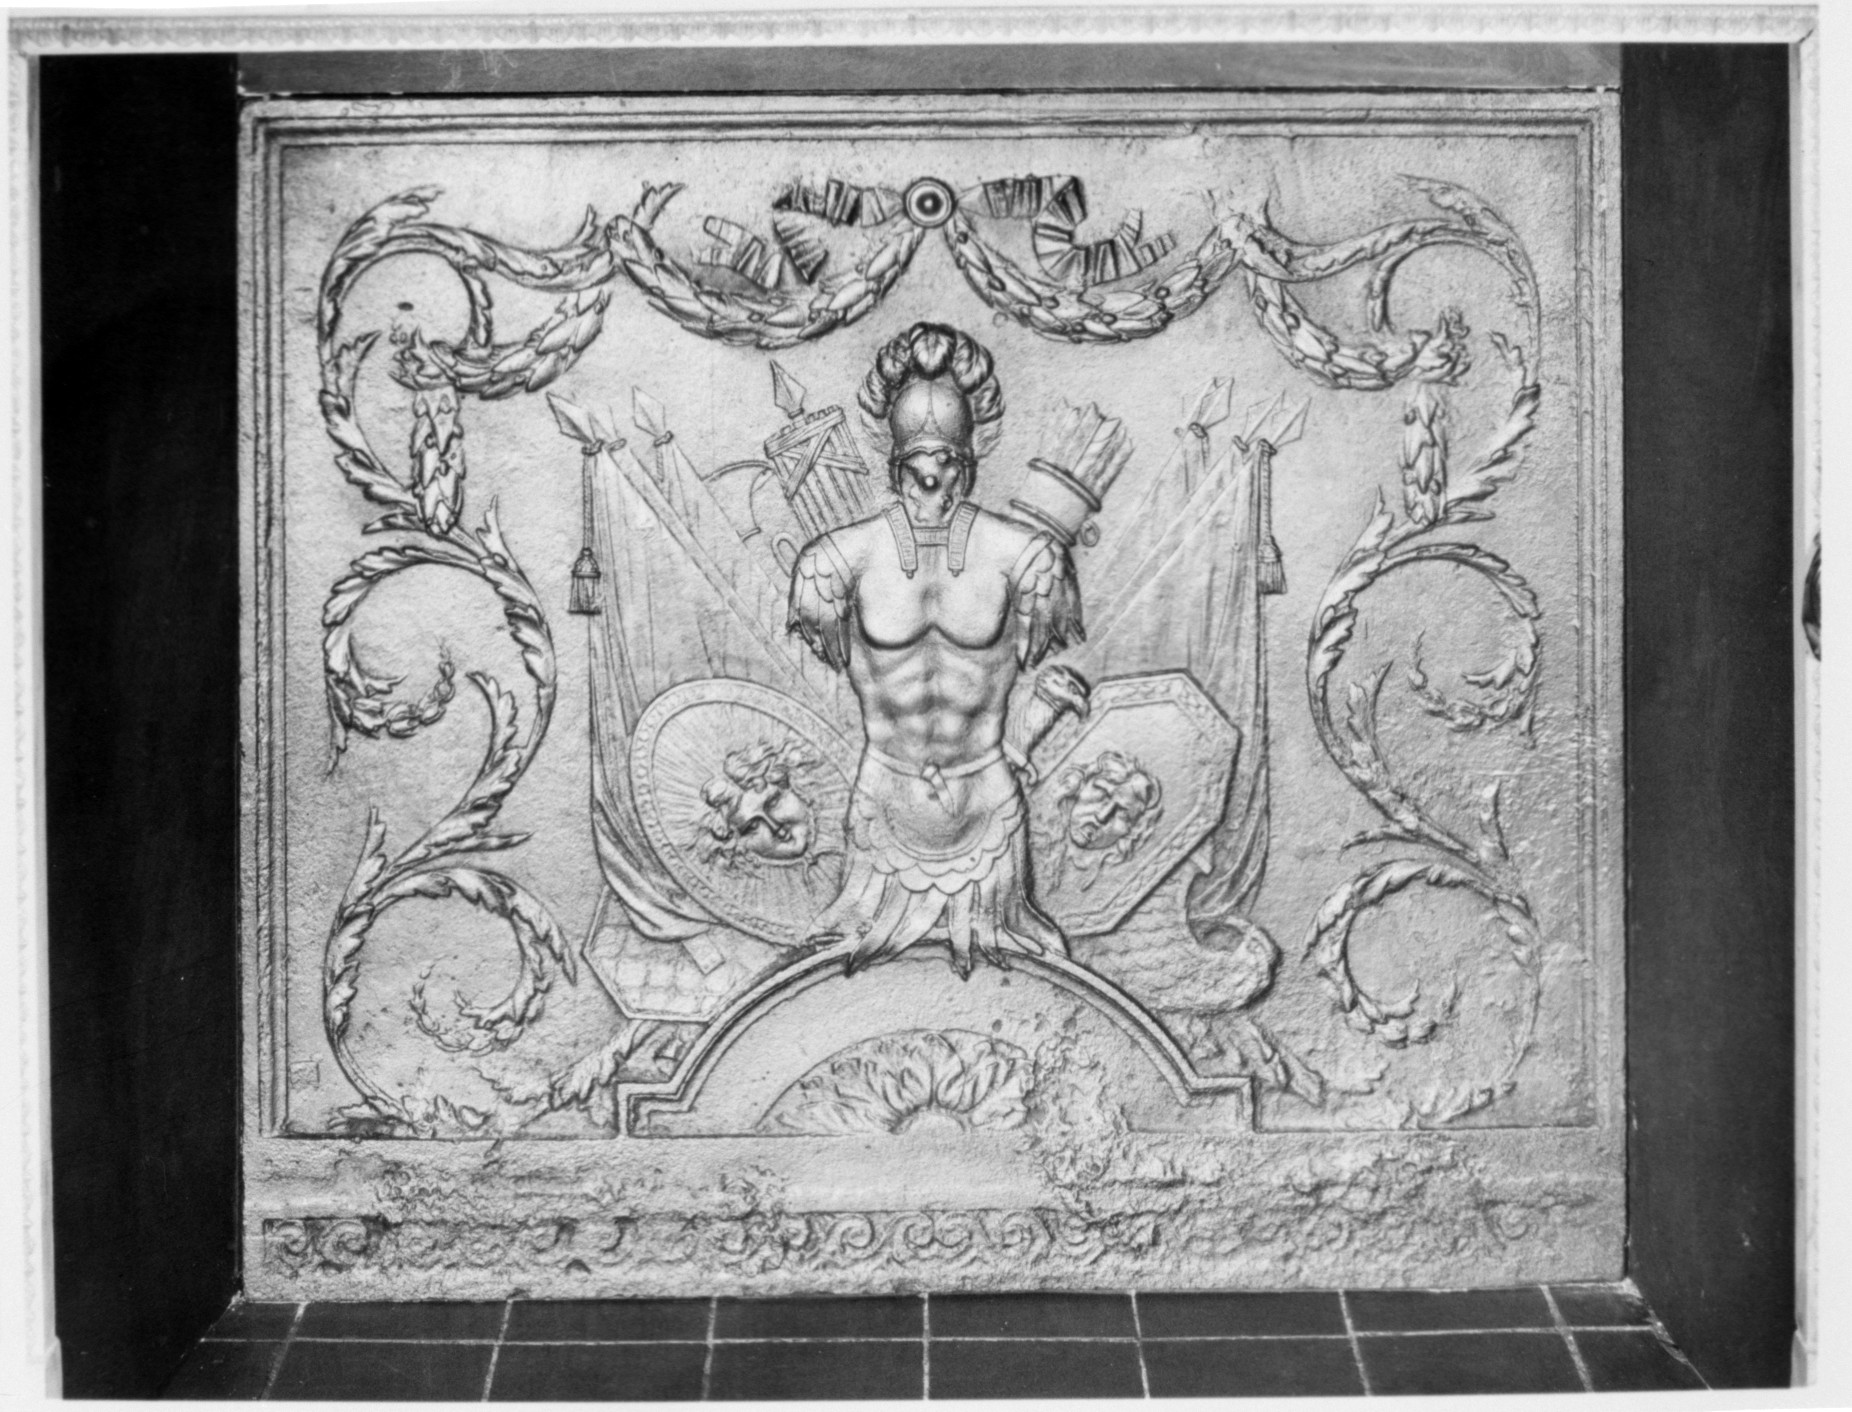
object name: fireback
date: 1775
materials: iron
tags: faces,men